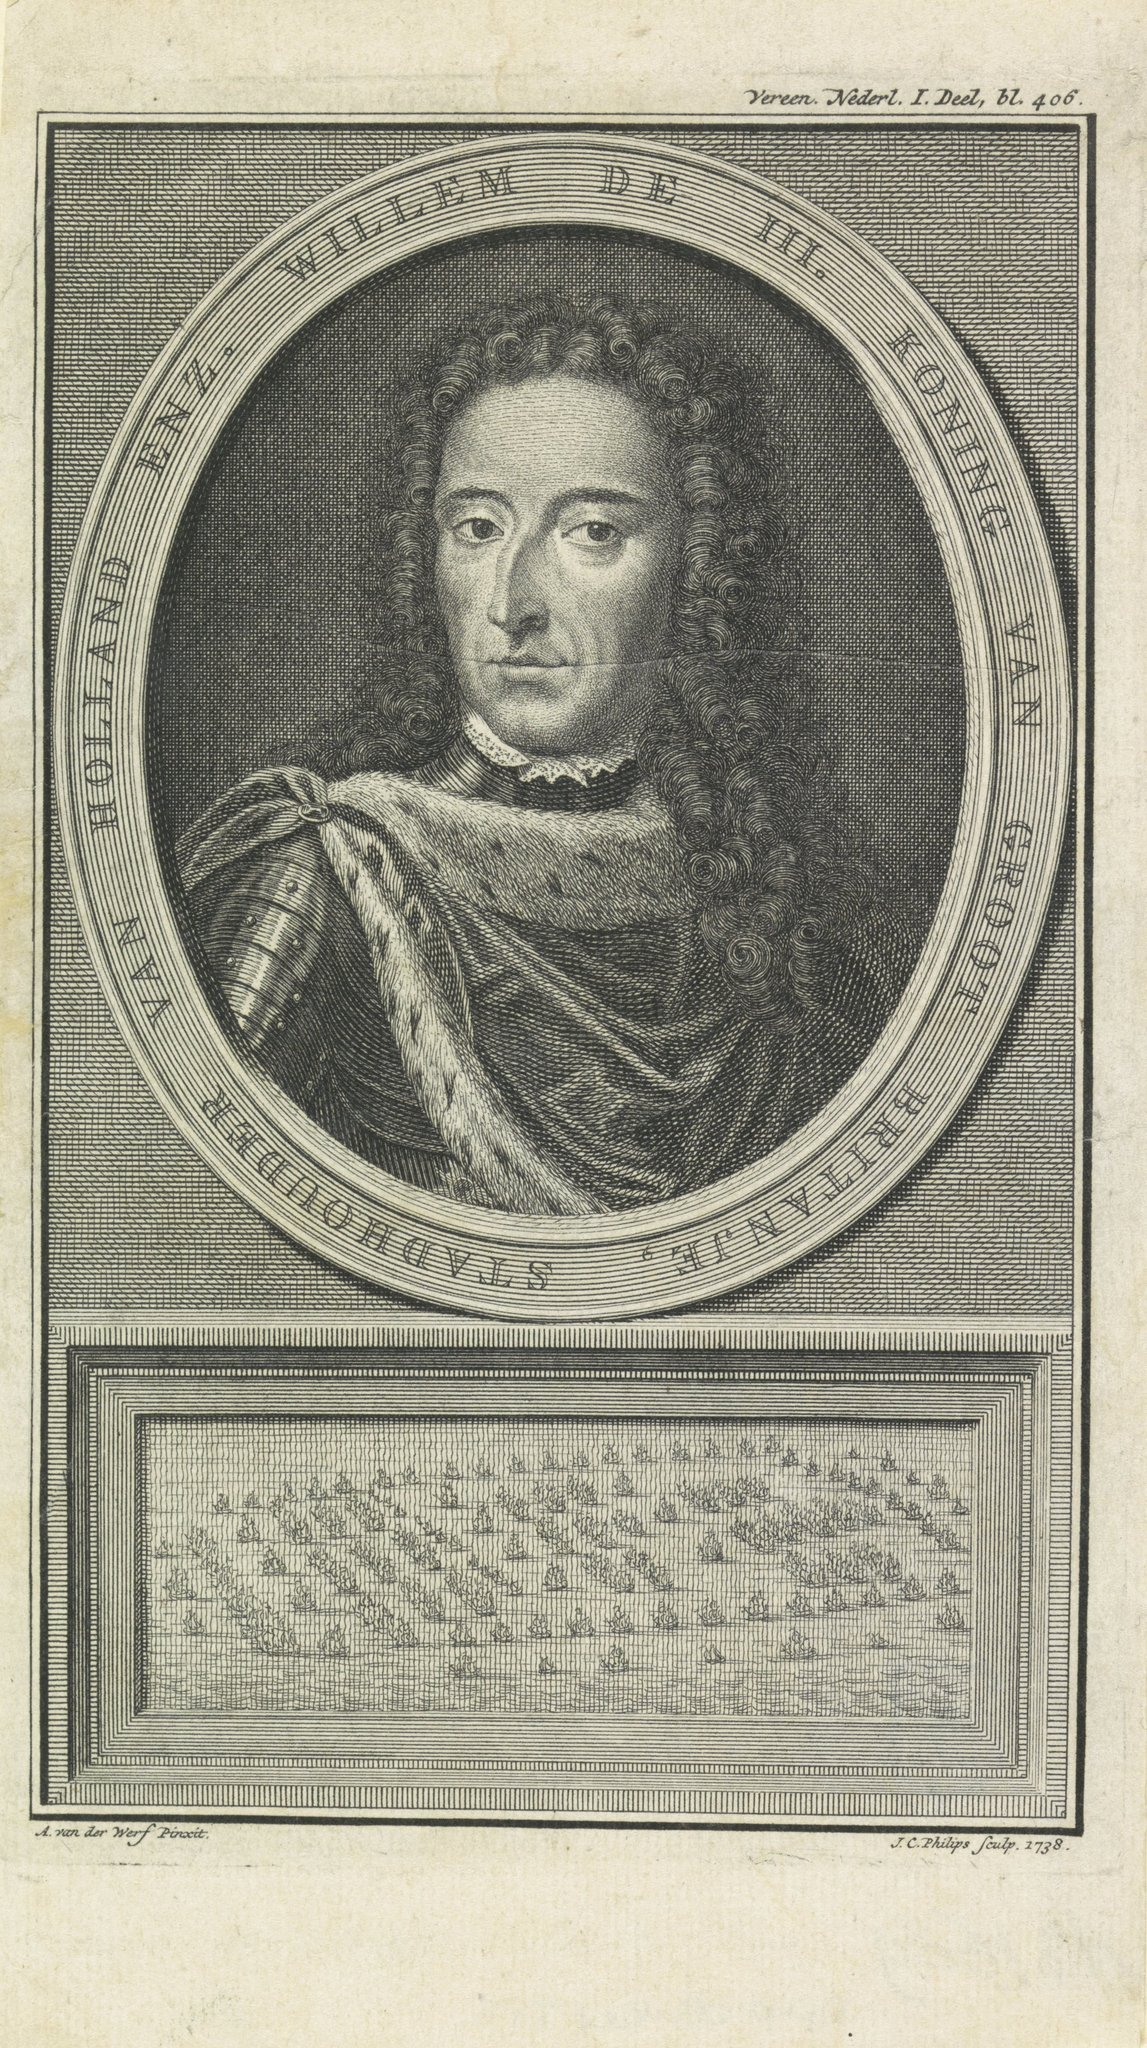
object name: print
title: Portret van Willem III, prins van Oranje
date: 1738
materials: paper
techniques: engraving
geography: amsterdam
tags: the hague, william iii (prince of orange and king of england, scotland, and ireland)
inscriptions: collector's mark: Lugt 963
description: De hier vermelde titel verwijst naar de hoogst verkregen titel van de geportretteerde, niet per se naar de titel die de geportretteerde op deze voorstelling draagt. Prent uit: Vereen. Nederl.